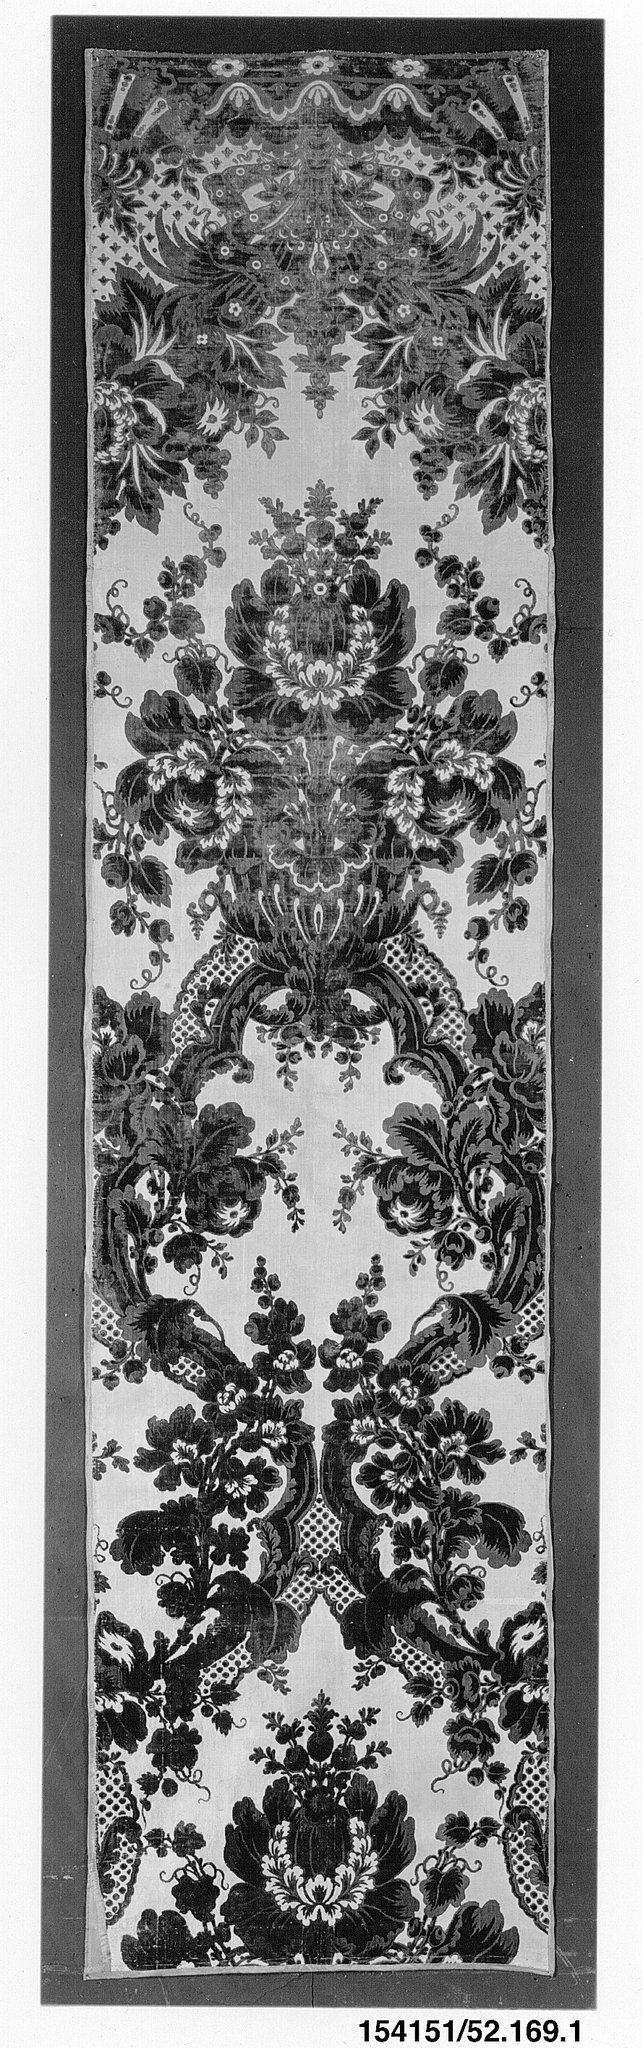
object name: piece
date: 1715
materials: silk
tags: flowers